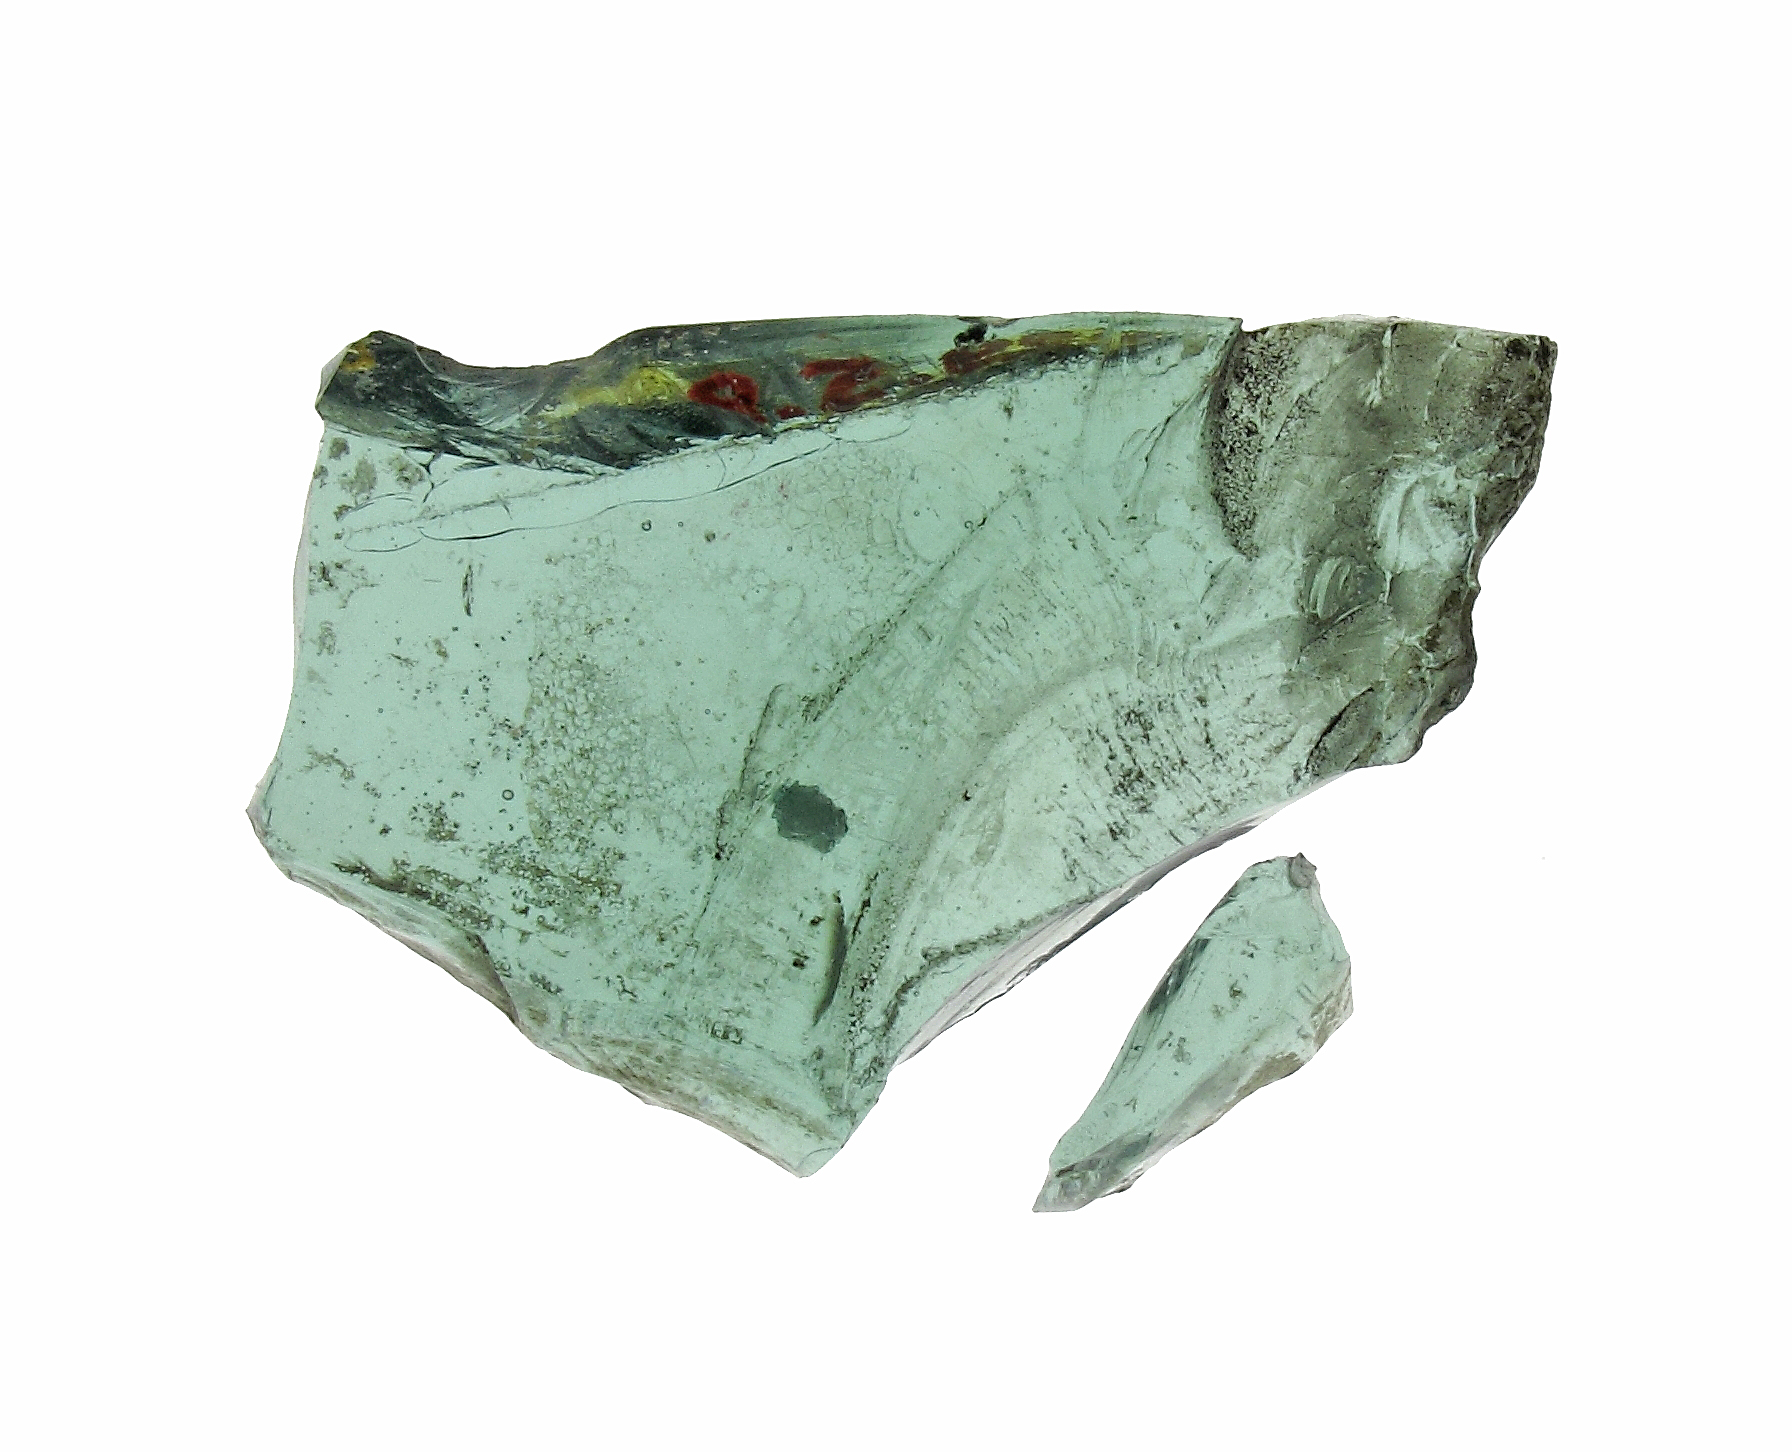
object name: fragment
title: Glass Fragment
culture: french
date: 1301-1400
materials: glass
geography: france